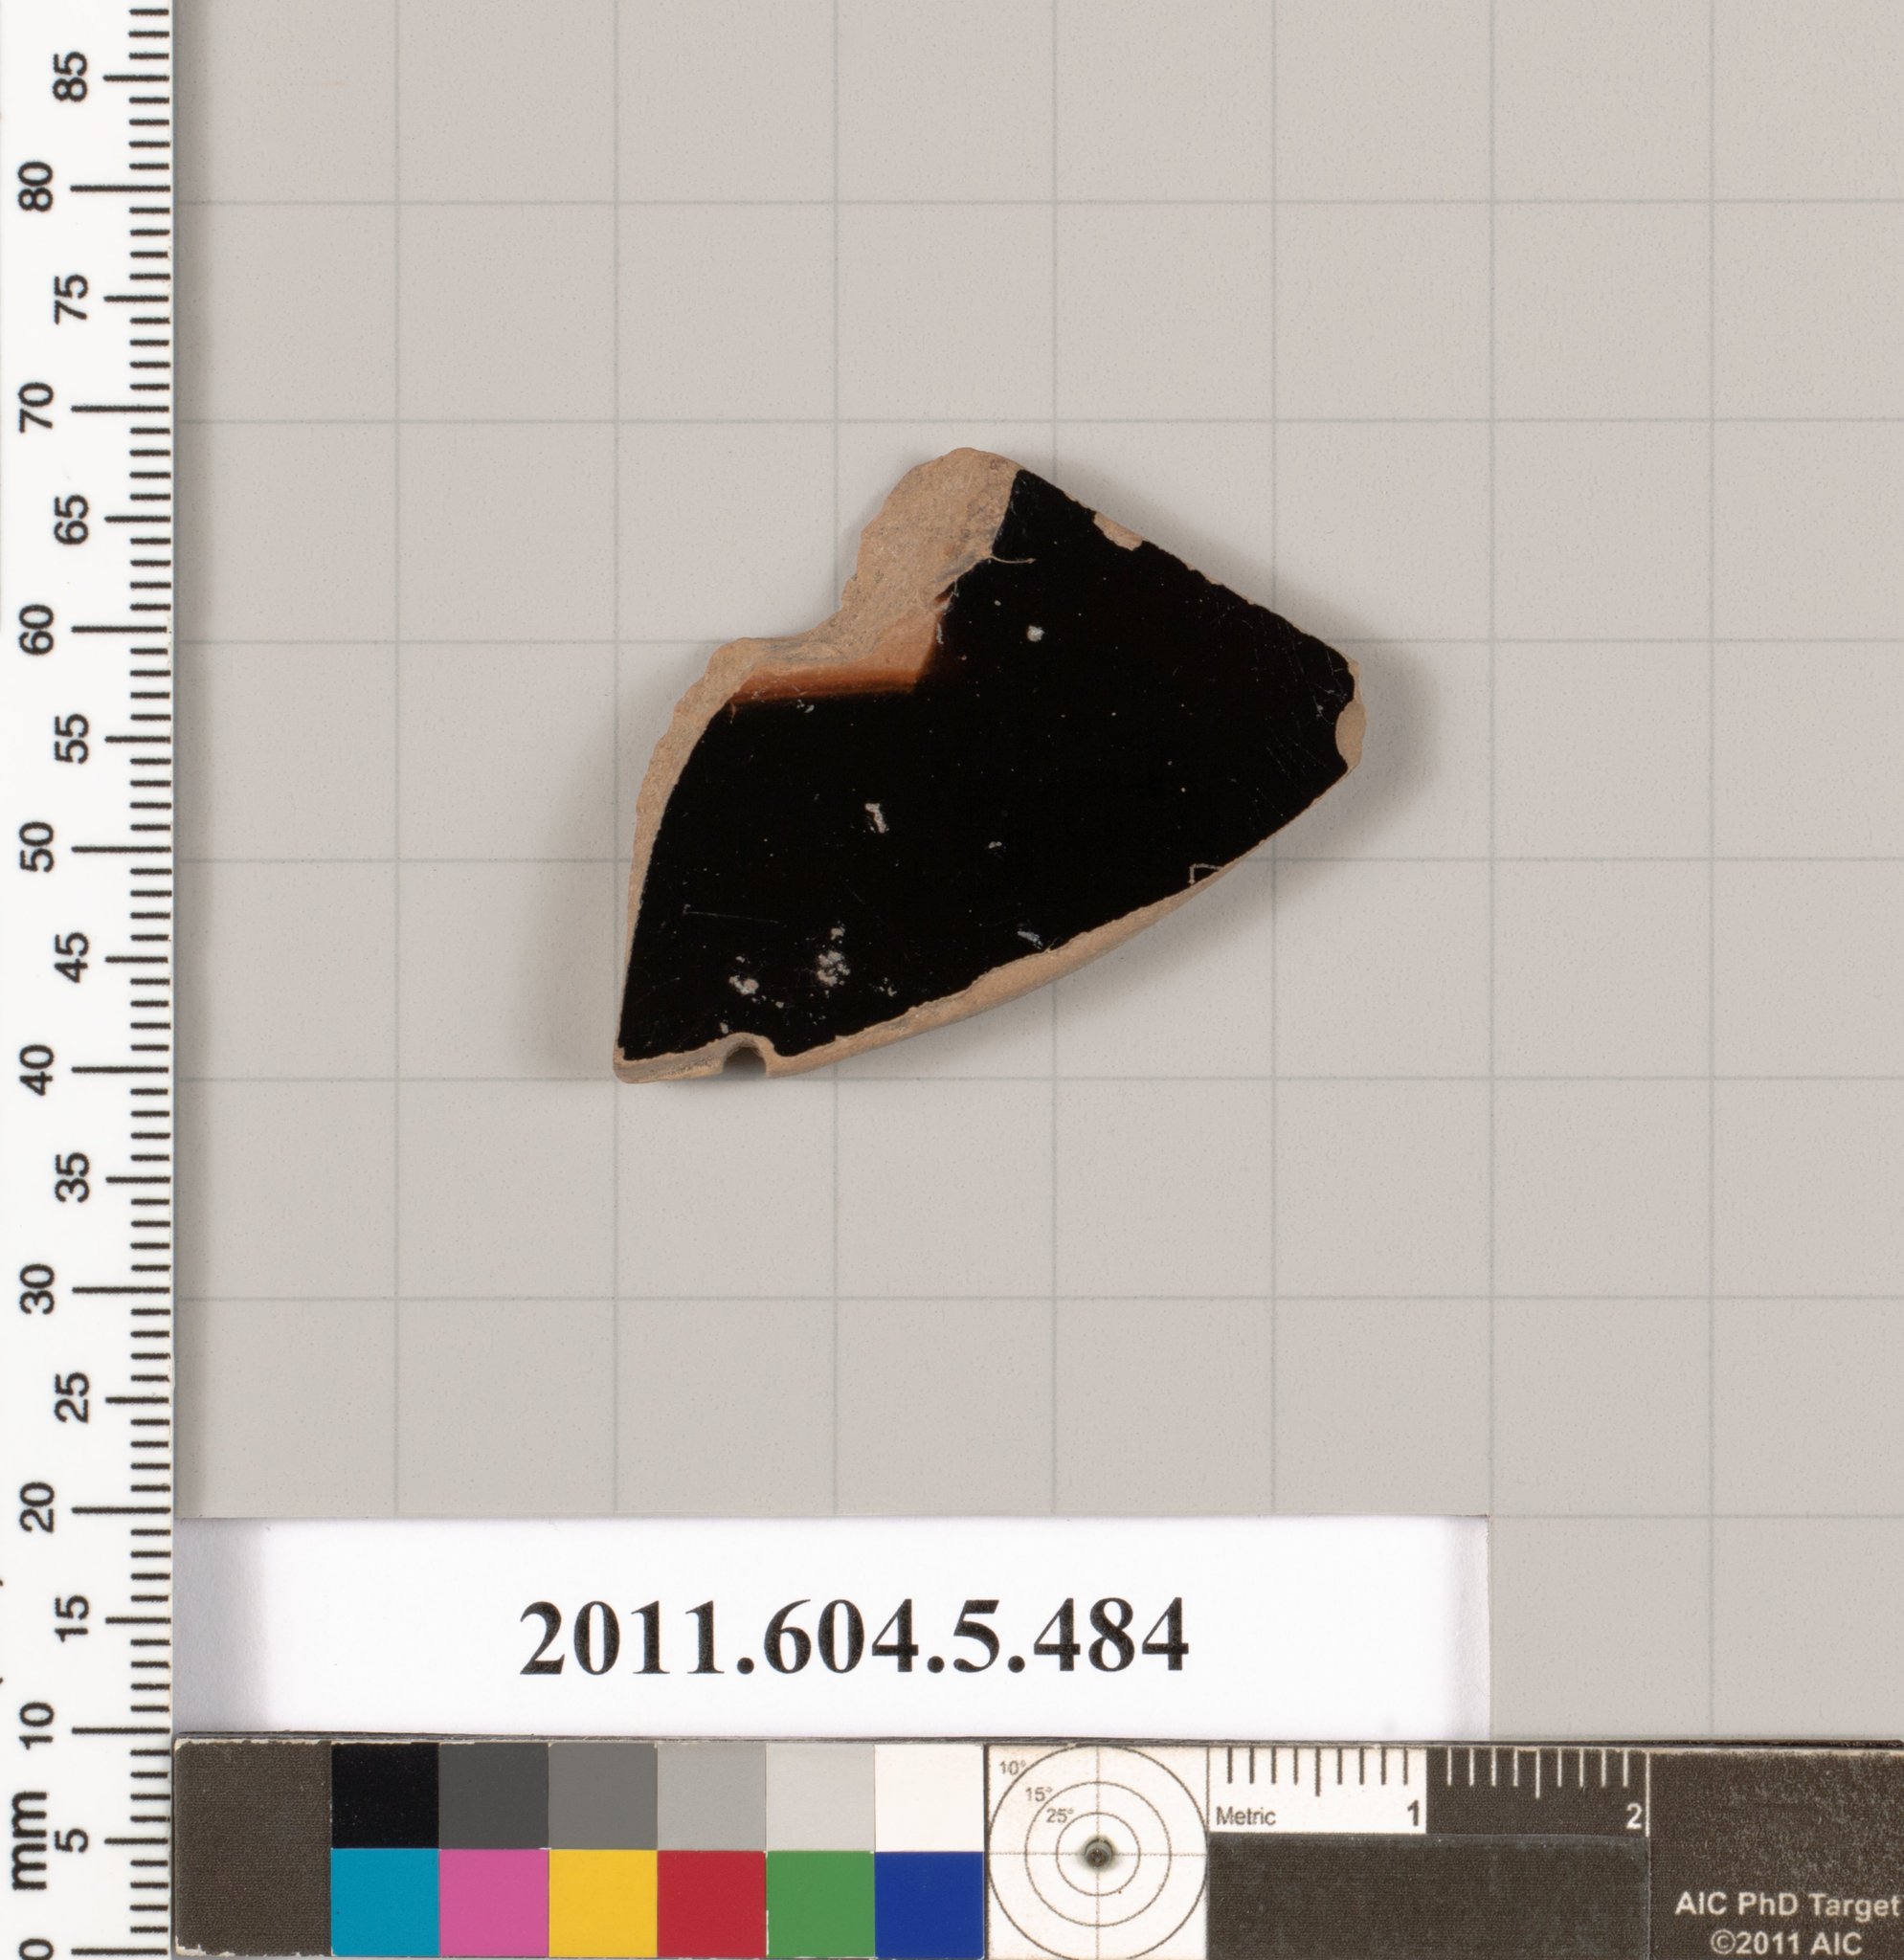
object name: kylix fragment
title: Terracotta fragment of a kylix (drinking cup)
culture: greek, attic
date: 600-401 BCE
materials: terracotta